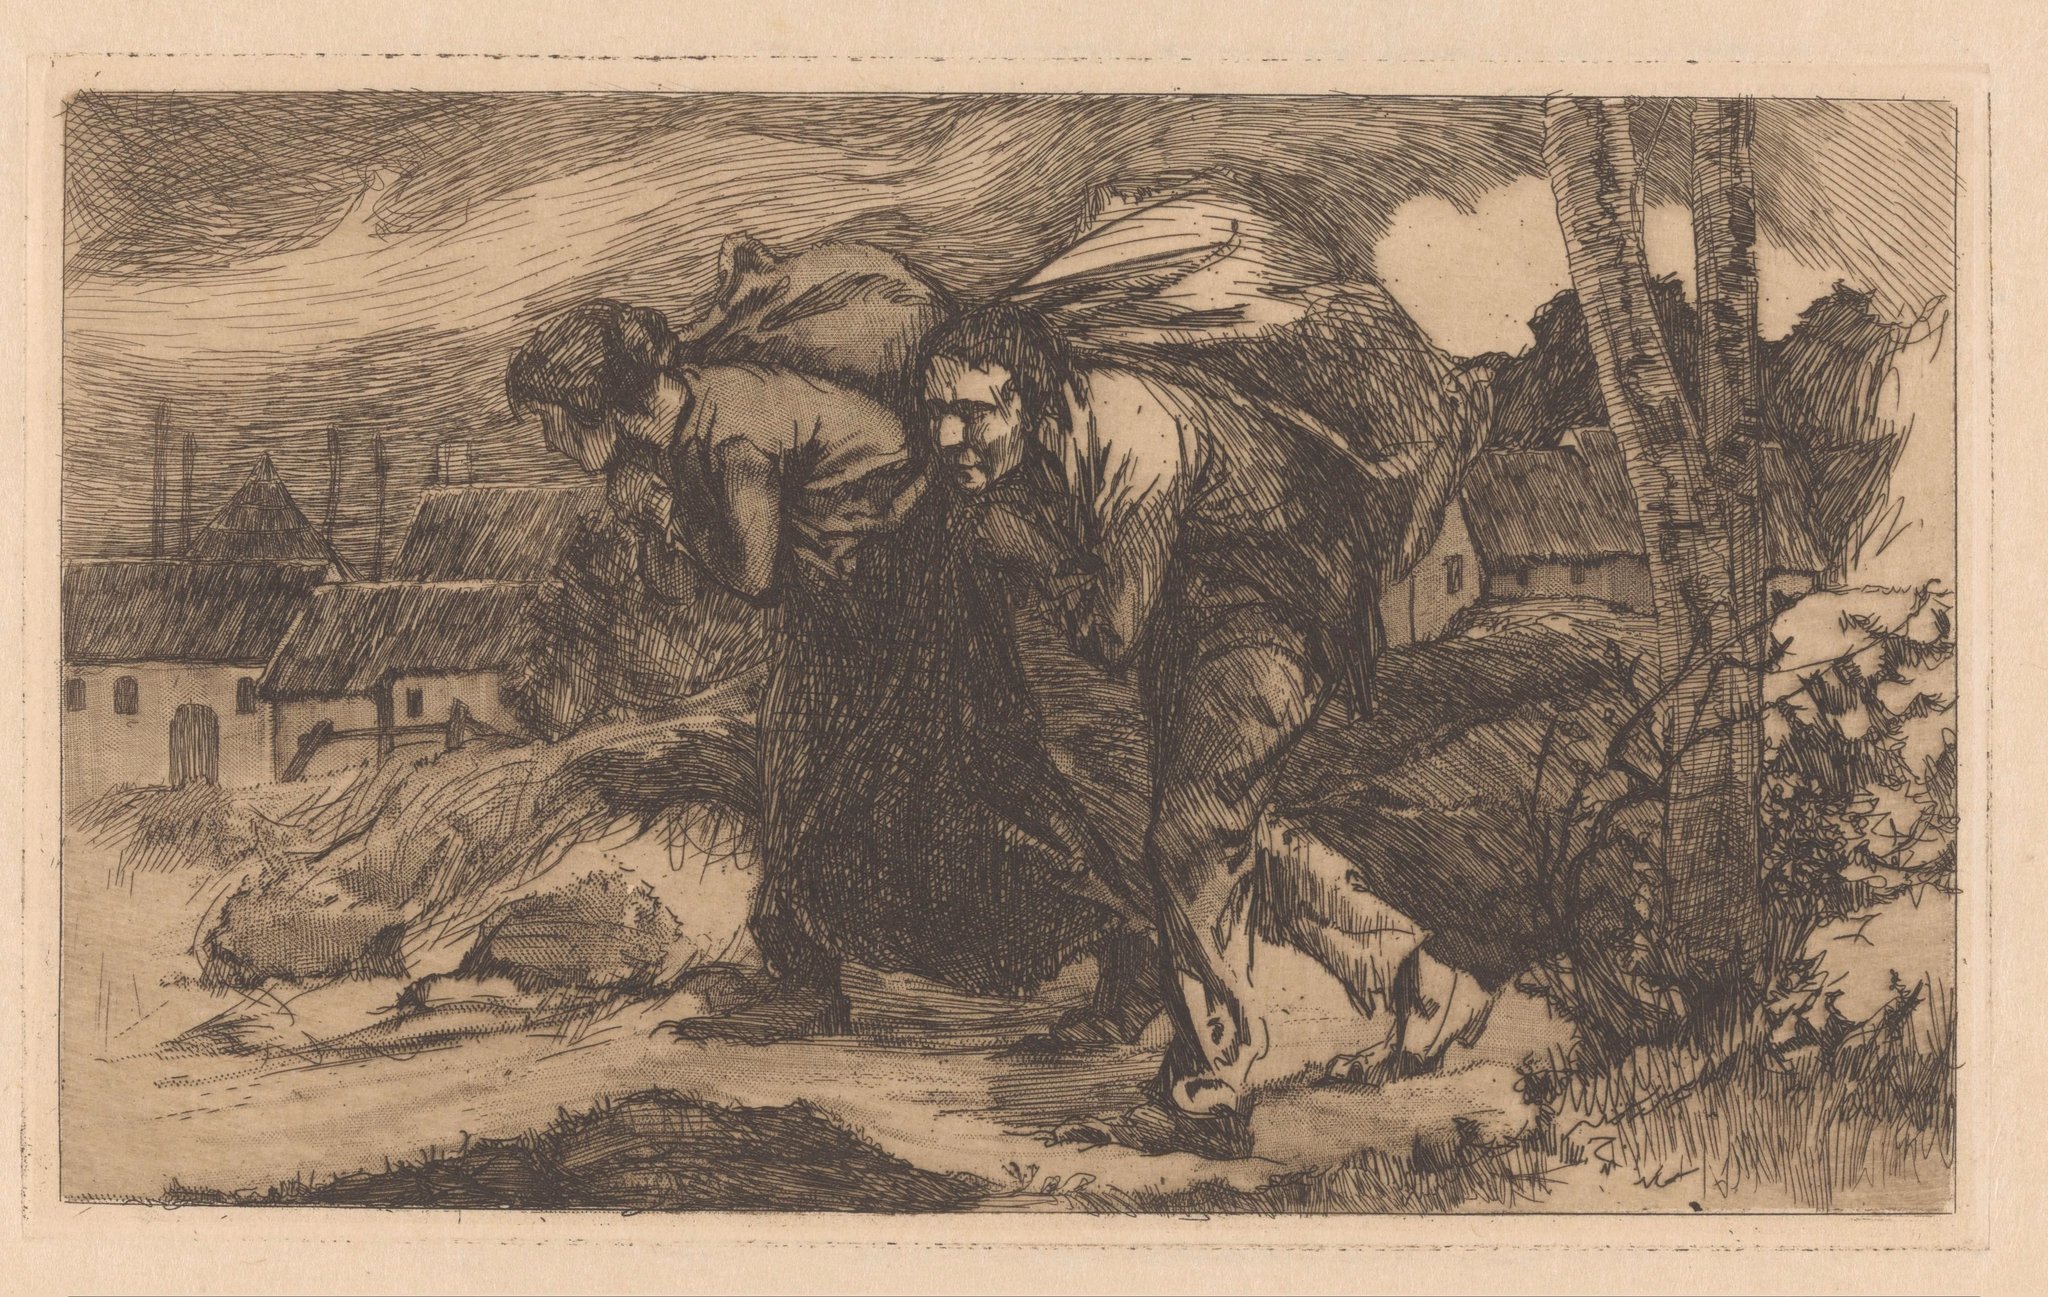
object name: print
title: Man en vrouw met zak op de rug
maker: johannes josephus aarts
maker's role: draughtsman, print maker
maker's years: 1871-1934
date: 1914-1915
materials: paper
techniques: etching, intaglio, roulette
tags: luggage, travel requisites, heaviness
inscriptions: collector's mark: Lugt 2760, collector's mark: Lugt 2228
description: Een man en vrouw dragen beide in voorovergebogen houding een zak op hun rug, mogelijk met aardappelen. Ze bevinden zich in een glooiend landschap met daarin een nederzetting.